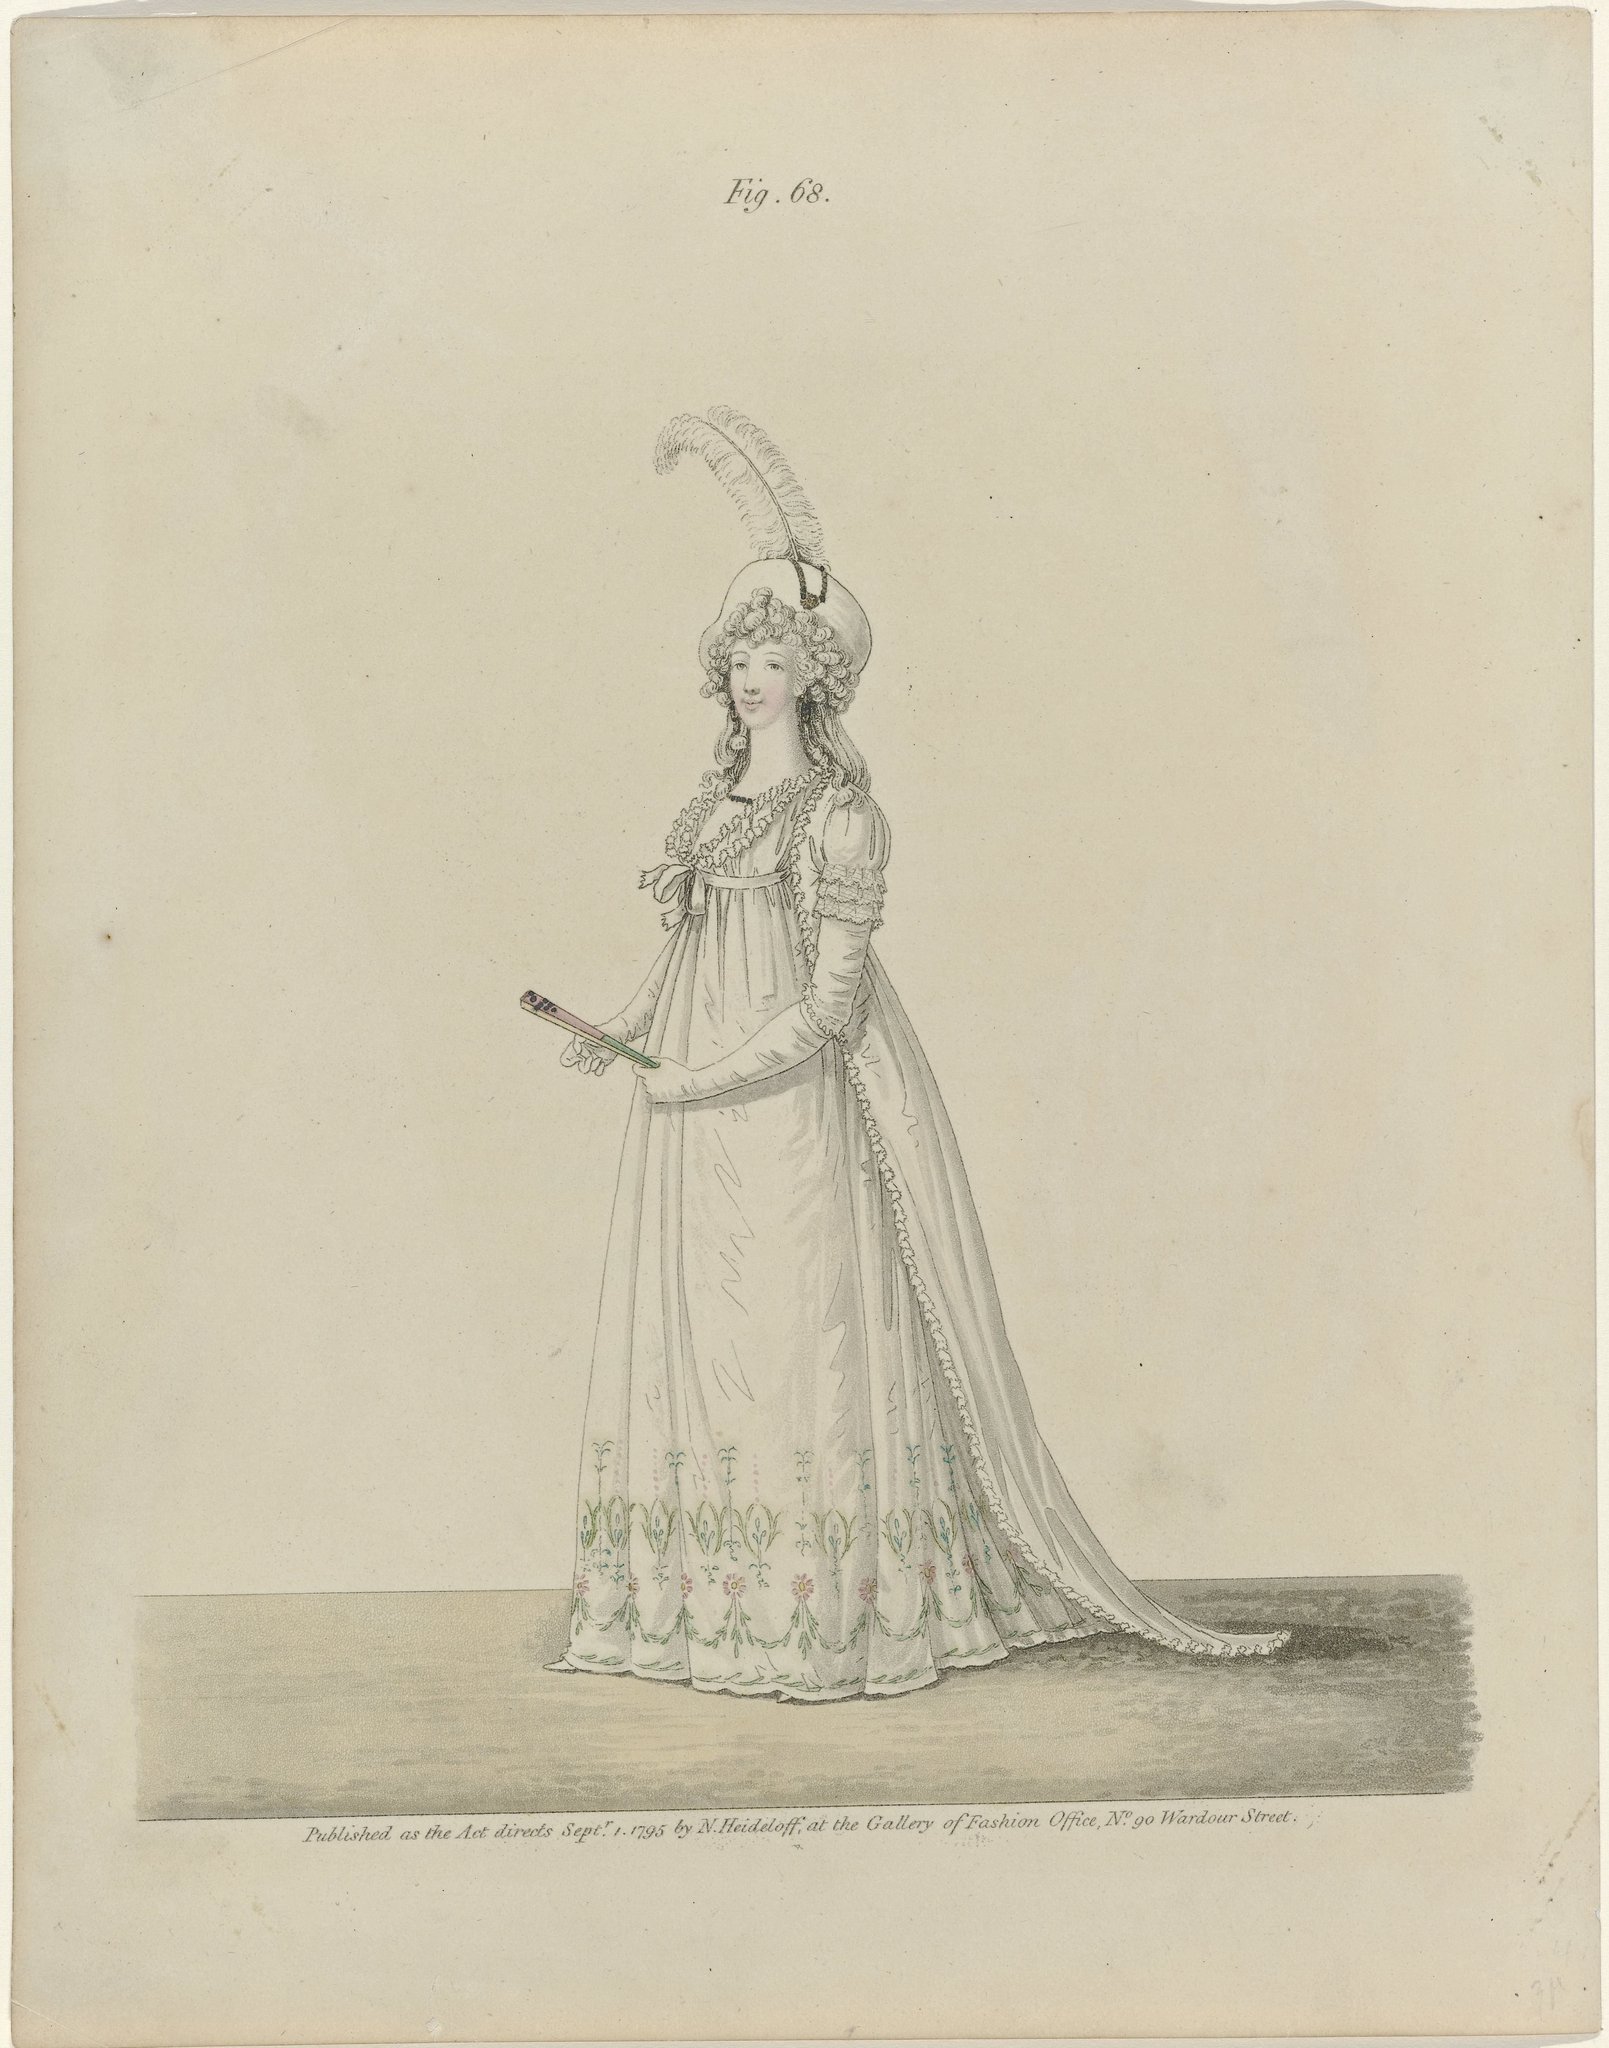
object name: fashion print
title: The Gallery of Fashion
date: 1795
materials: paper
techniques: aquatint, etching, hand coloring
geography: london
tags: ear-rings (+ women's clothes), fashion plates, head-gear: hat (+ women's clothes), dress, gown (+ women's clothes), fan (+ women's clothes), belt, girdle, waistband (+ women's clothes)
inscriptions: address: ‘Published as the Act directs Sept.r 1, 1795, by N. Heideloff, at the Gallery of Fashion Office, No. 90 Wardour Street.’, inscription: ‘Fig. 68.’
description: In 1794 The Gallery of Fashion first appeared in England. Clearly inspired by the French Gallerie des Modes, the series was intended, according to the publisher, to demonstrate the superiority of English taste. English fashions were more decorous, and sometimes exceptionally voluminous. The three ostrich plumes in the young ladies’ turbans were required for introductions at court, being an emblem of the Prince of Wales.